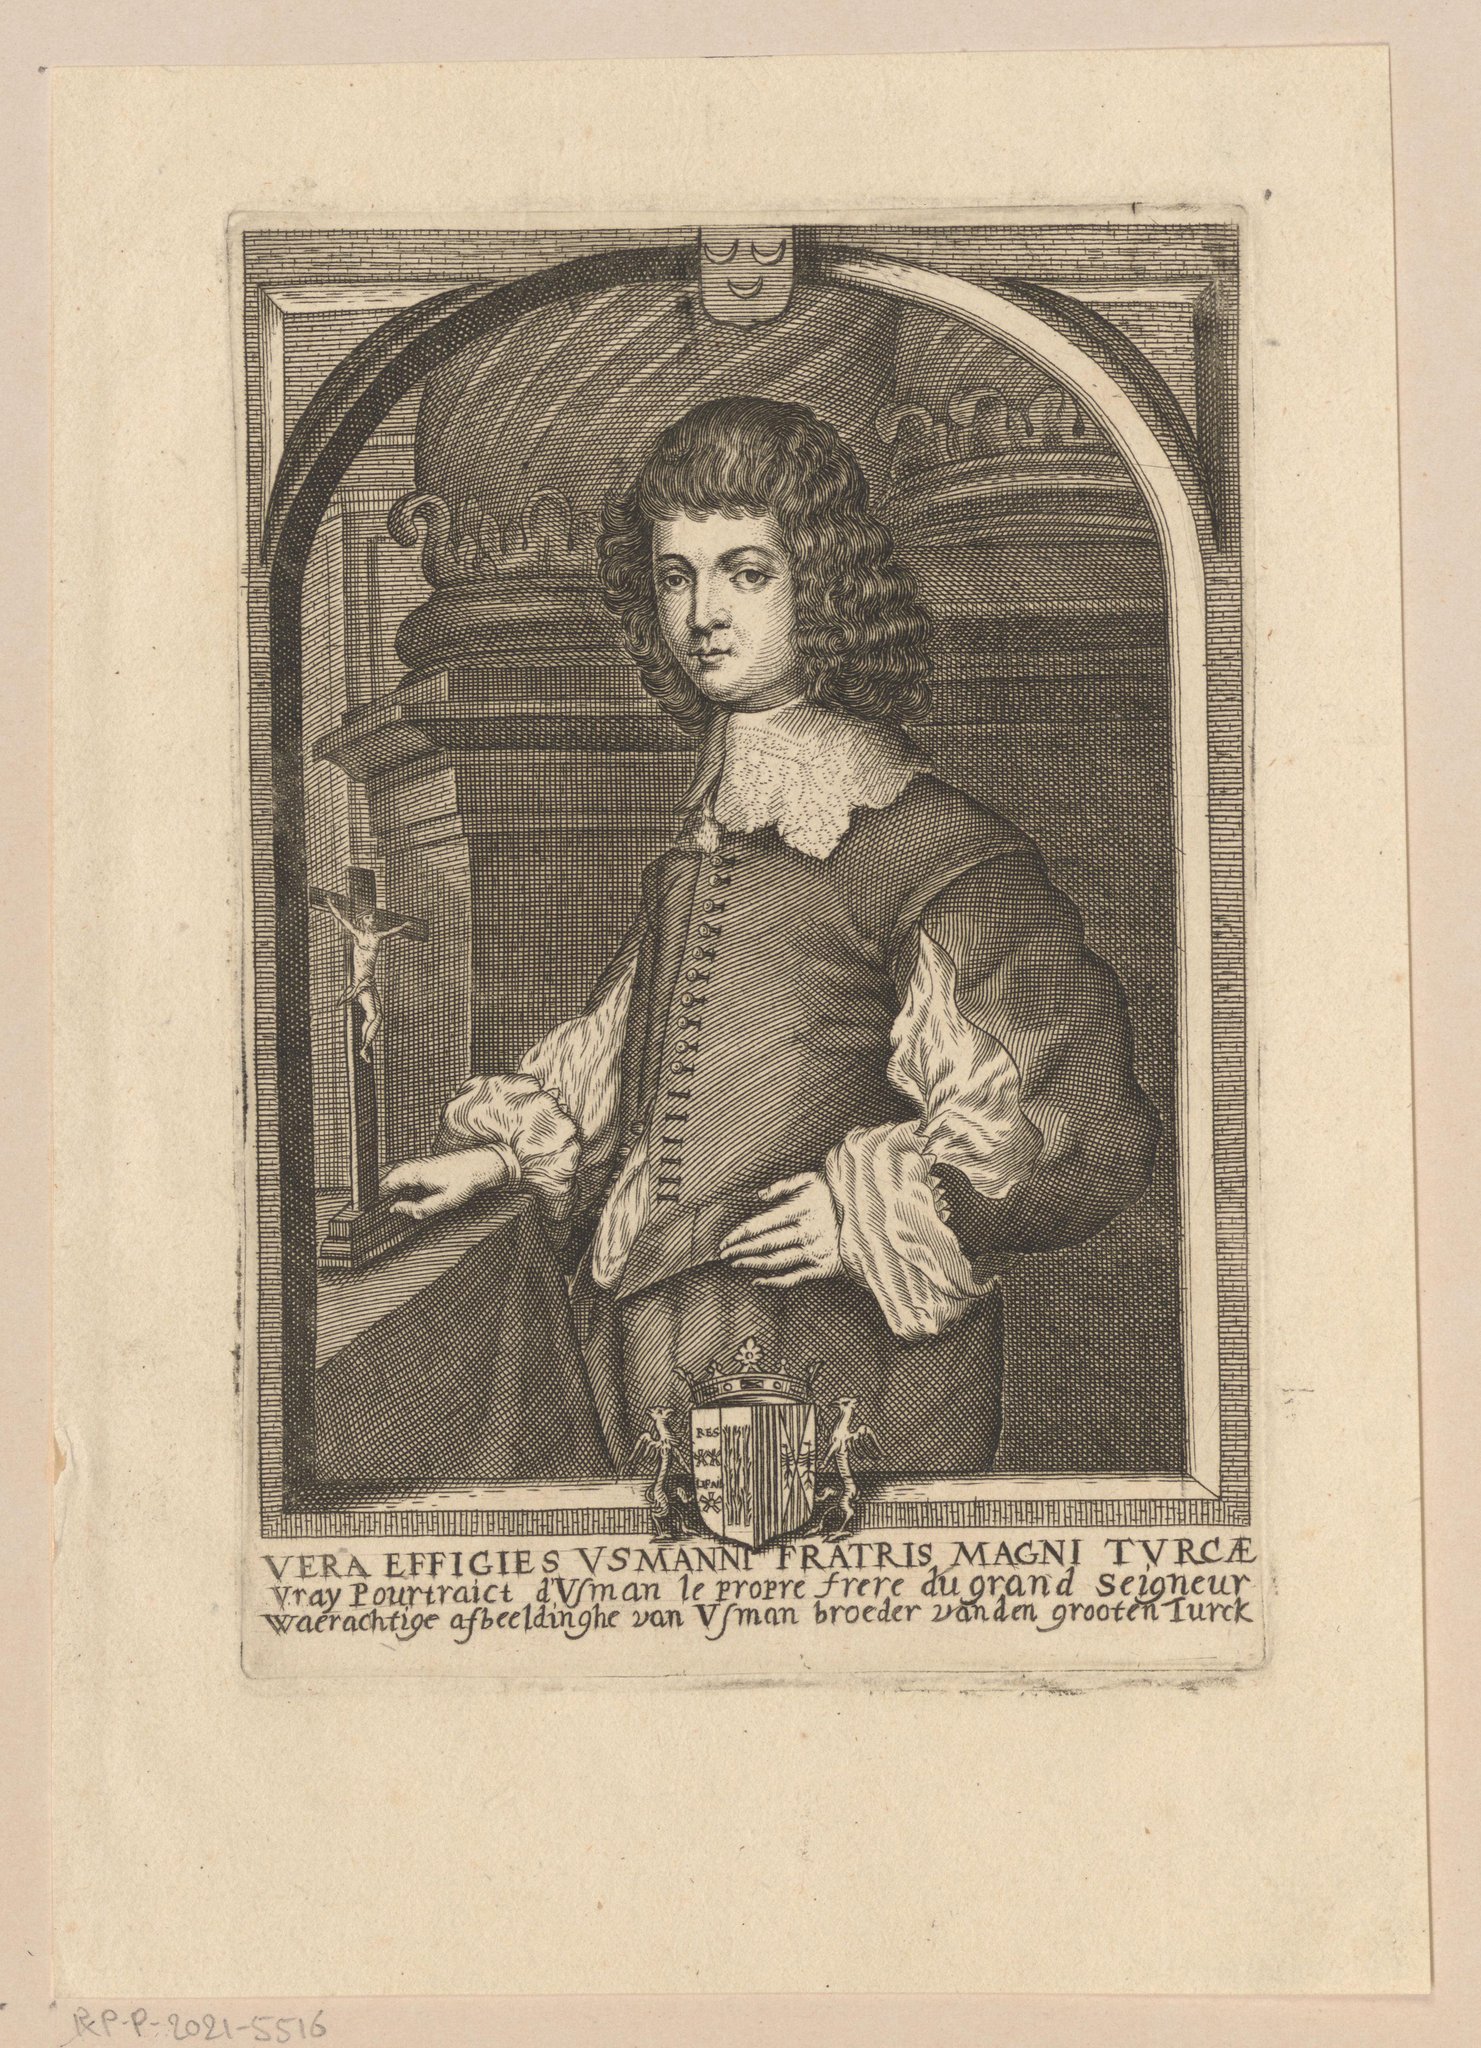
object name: print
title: Portret van Osman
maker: Anonymous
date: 1650-1699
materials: paper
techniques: engraving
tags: historical persons, armorial bearing, heraldry